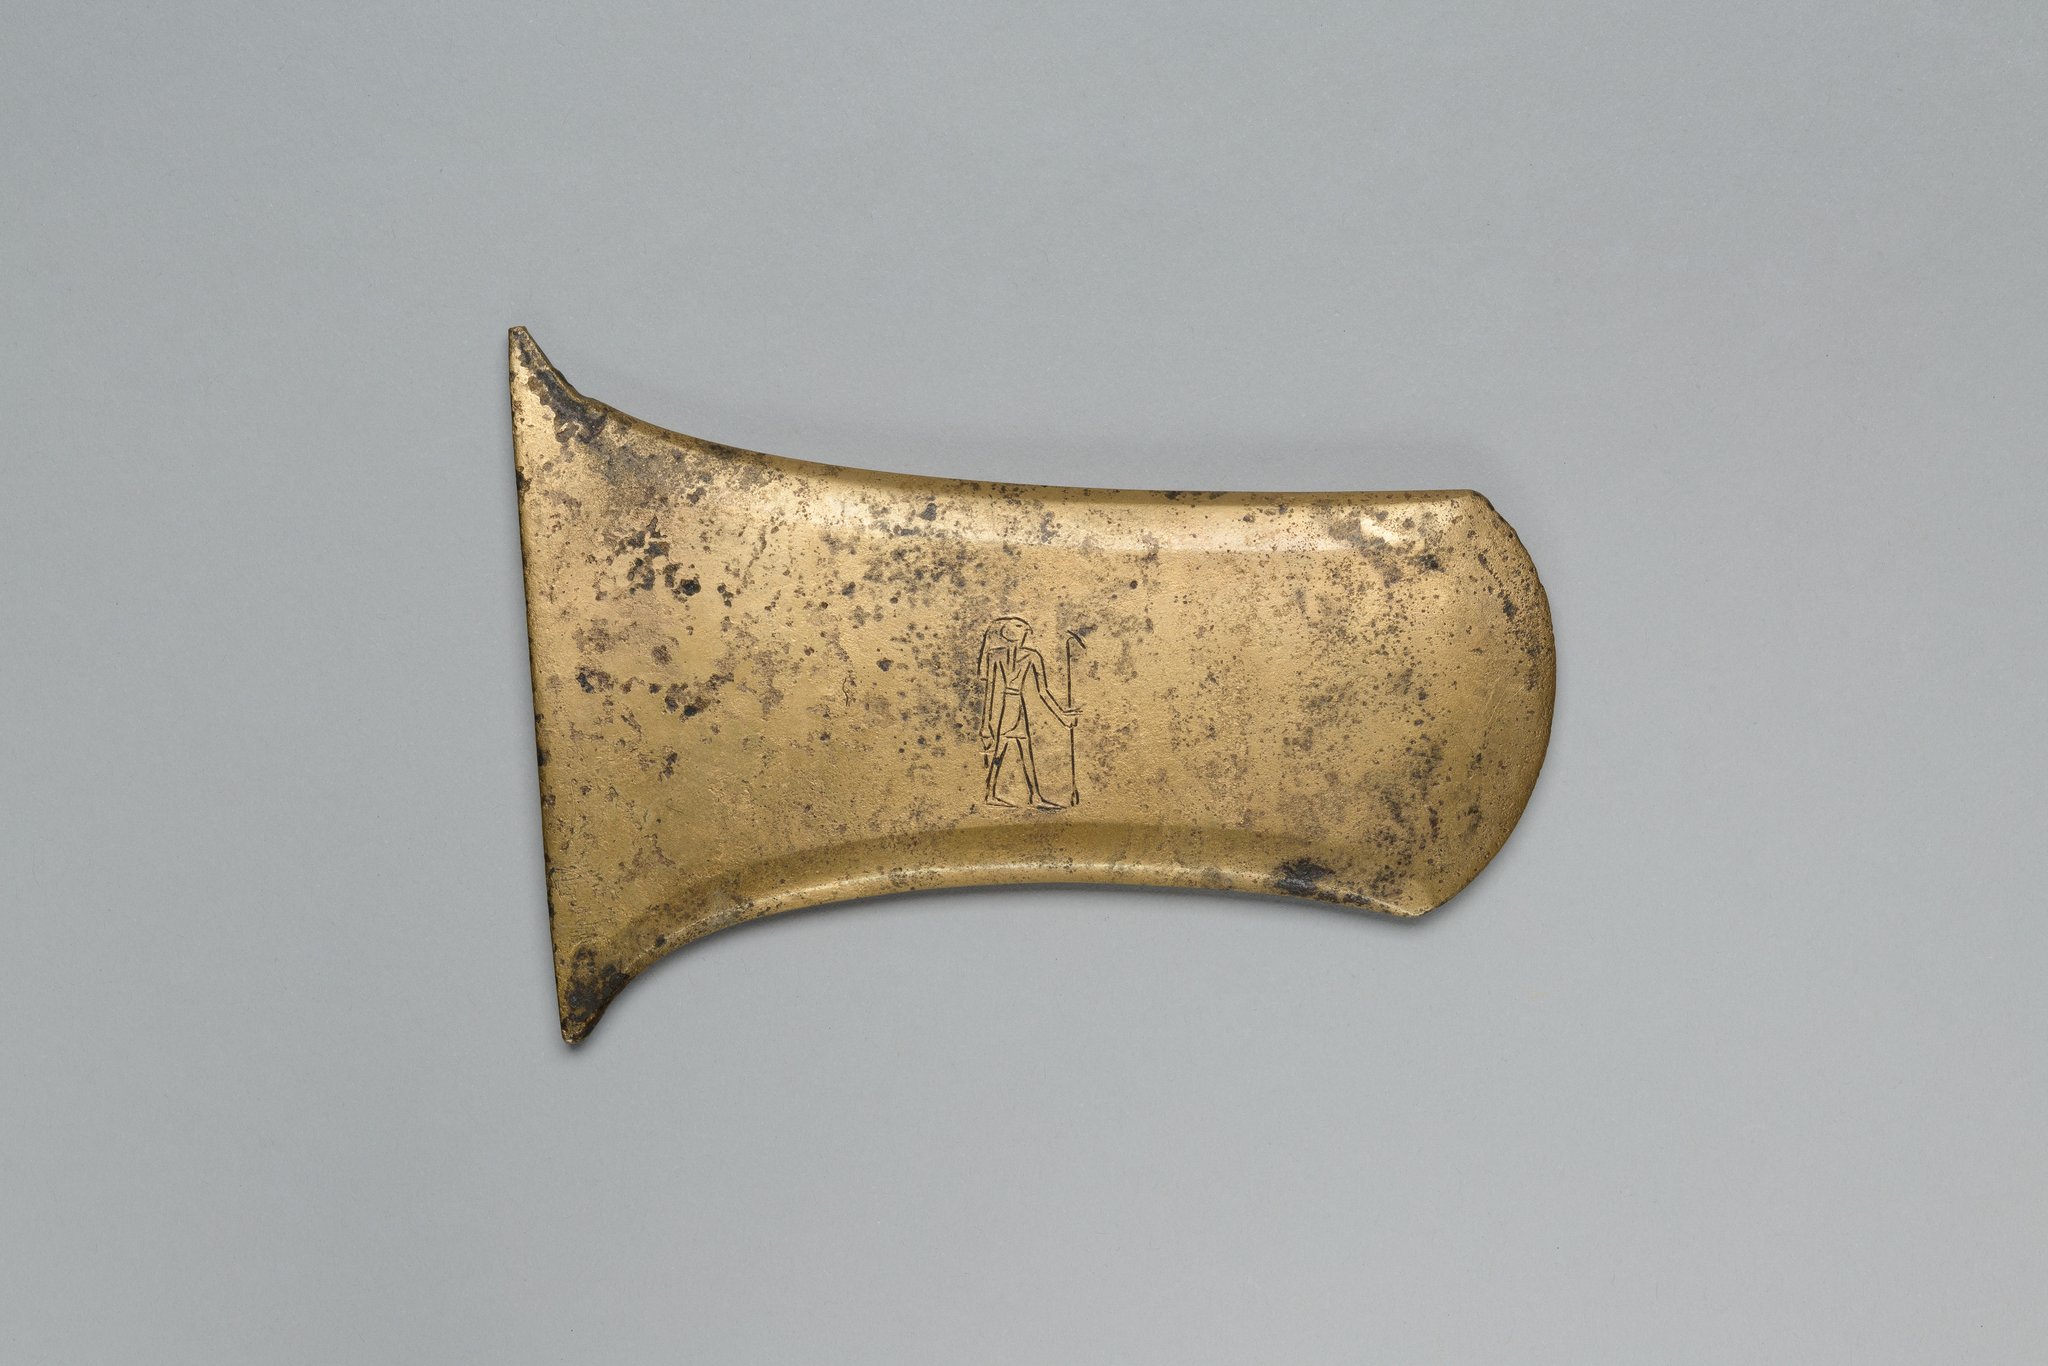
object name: ax blade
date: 1295-1070 BCE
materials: bronze, copper alloy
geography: egypt